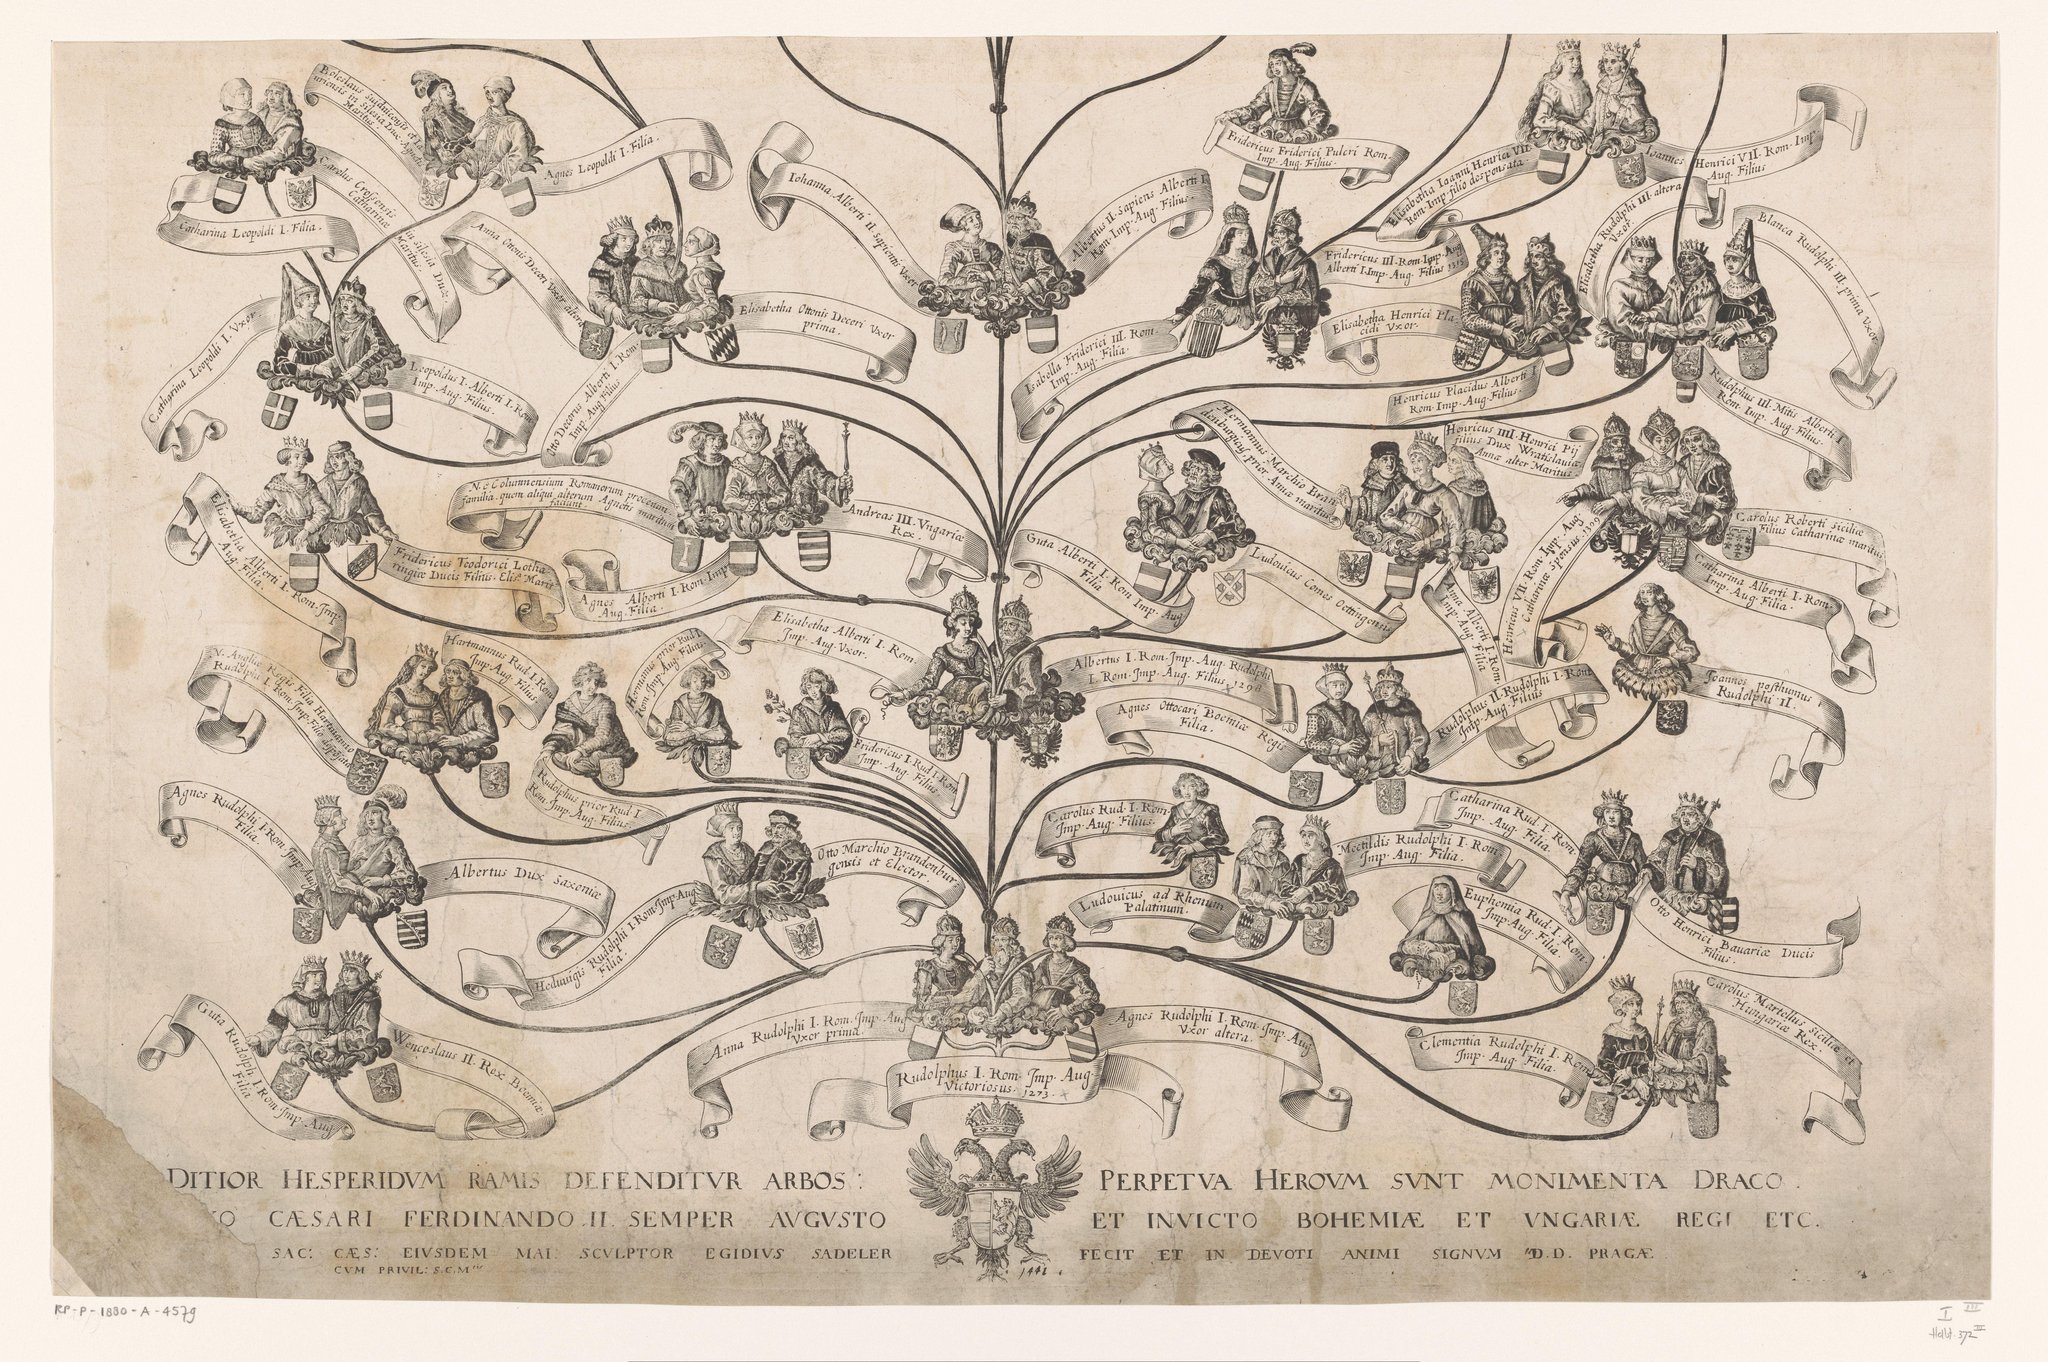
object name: print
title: Stamboom van het Habsburgse huis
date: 1629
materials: paper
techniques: engraving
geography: prague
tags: family lineage, pedigree, genealogical tree or table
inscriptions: collector's mark: Lugt 2228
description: Stamboom van het Habsburgse huis met onderaan Rudolf I van Habsburg. De prent behoort tot een serie bestaande uit zes prenten, waarvan één titelprent.